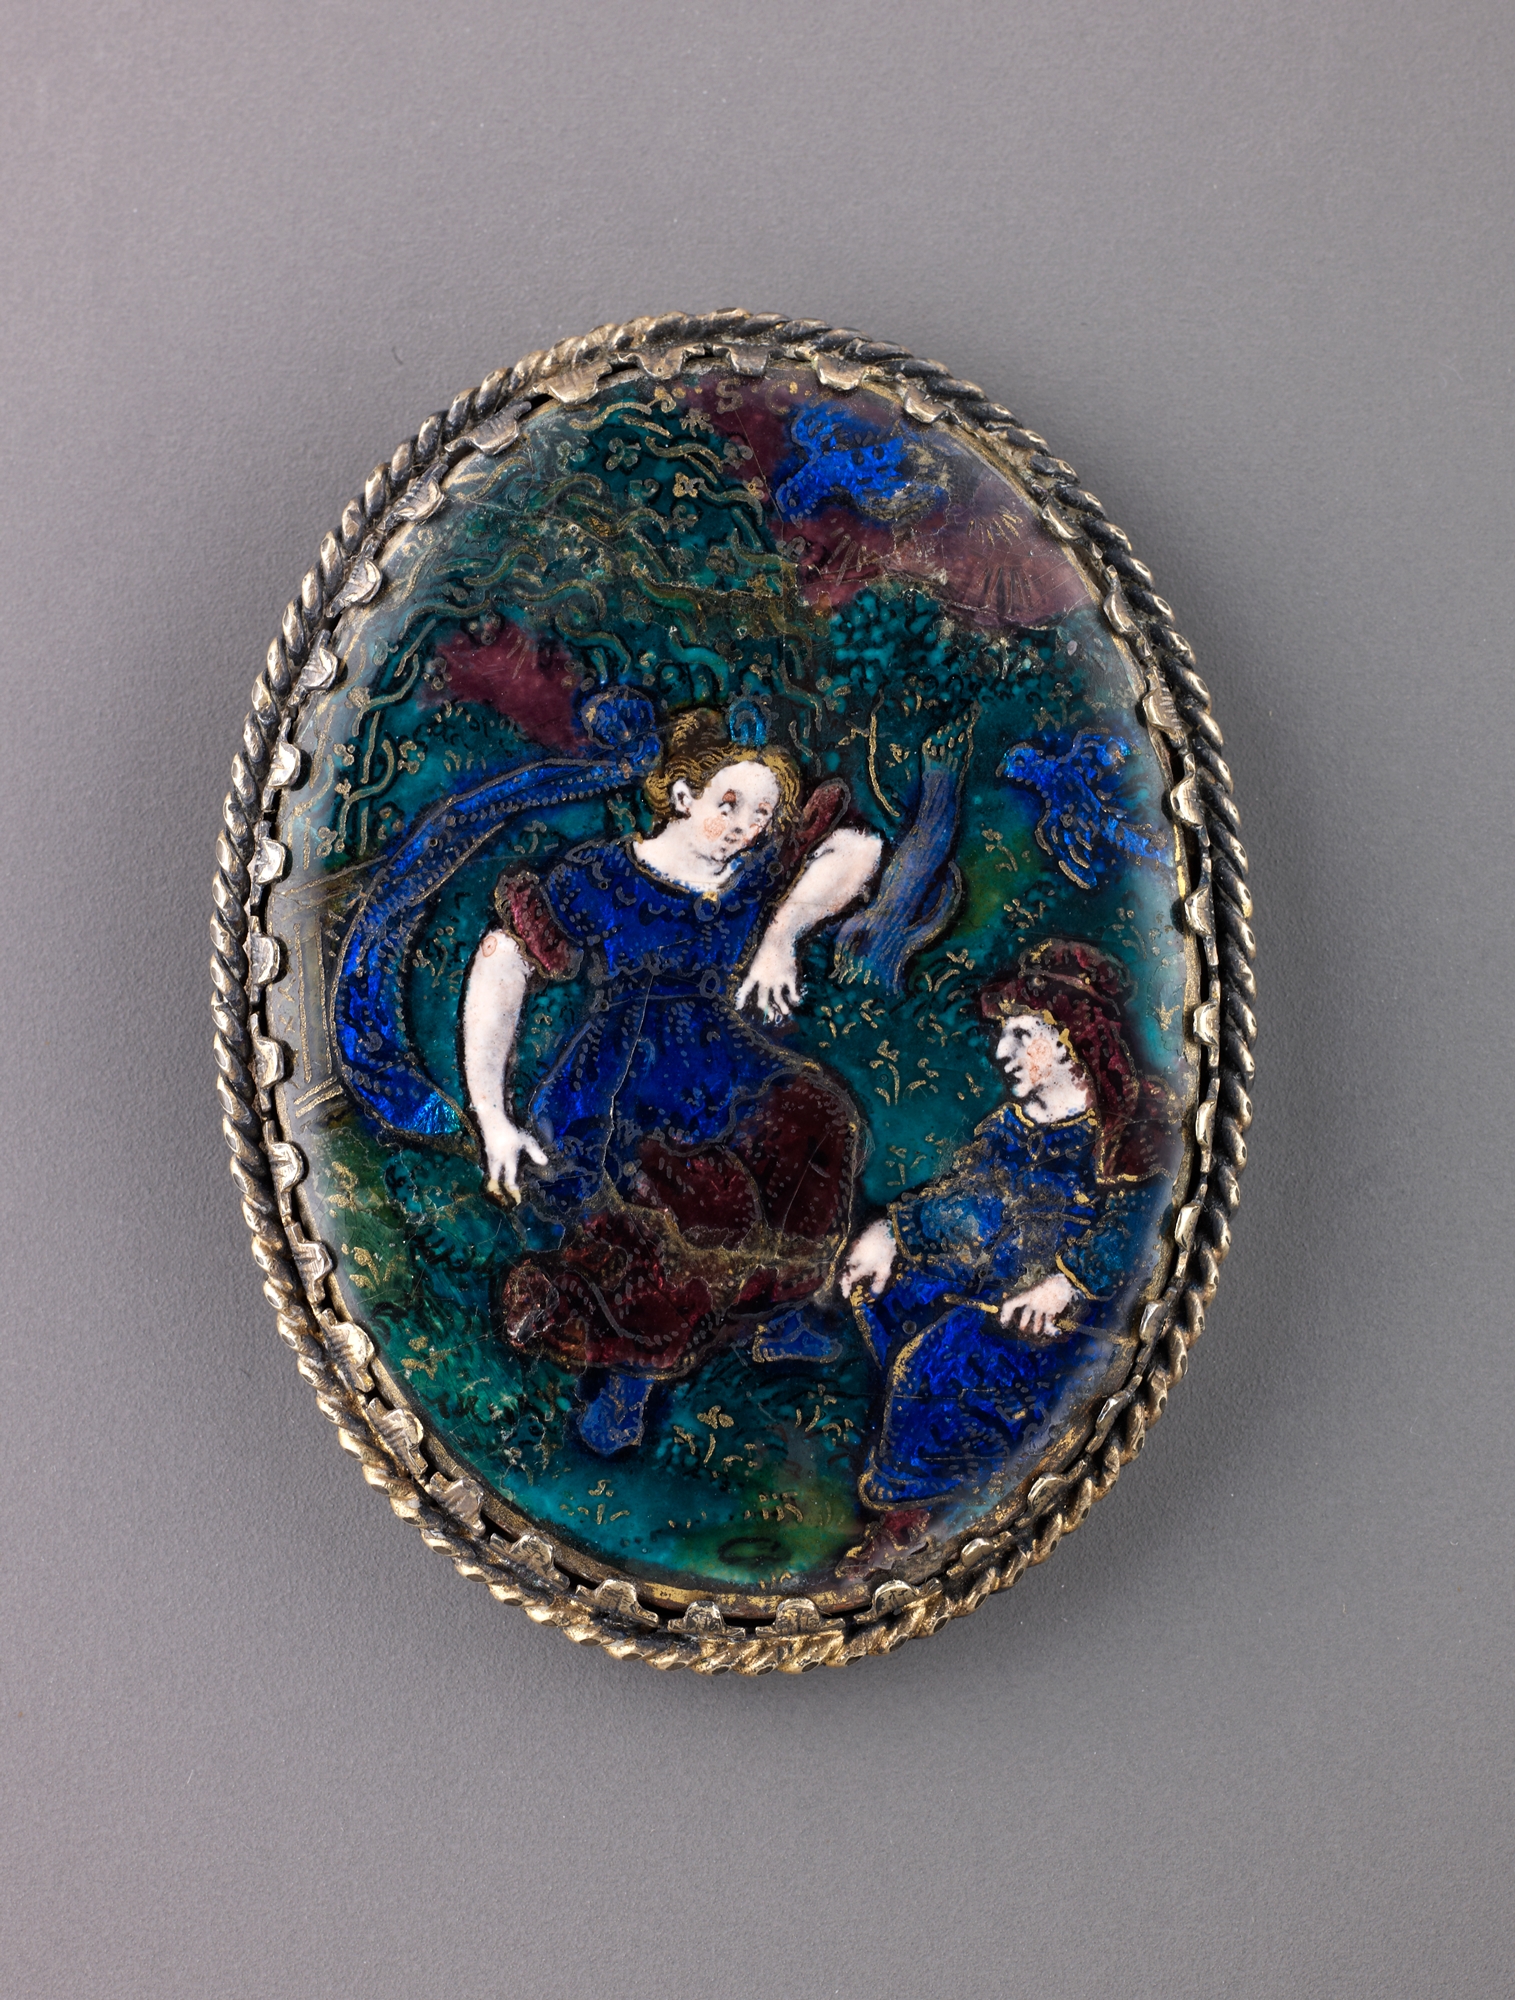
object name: watchcover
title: Watchcase cover: Pomona and Vertumnus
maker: suzanne de court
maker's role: artist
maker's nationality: french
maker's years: 1575-1625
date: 1601-1625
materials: brass, copper, enamel, gilt, silver gilt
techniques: painting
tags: men,women